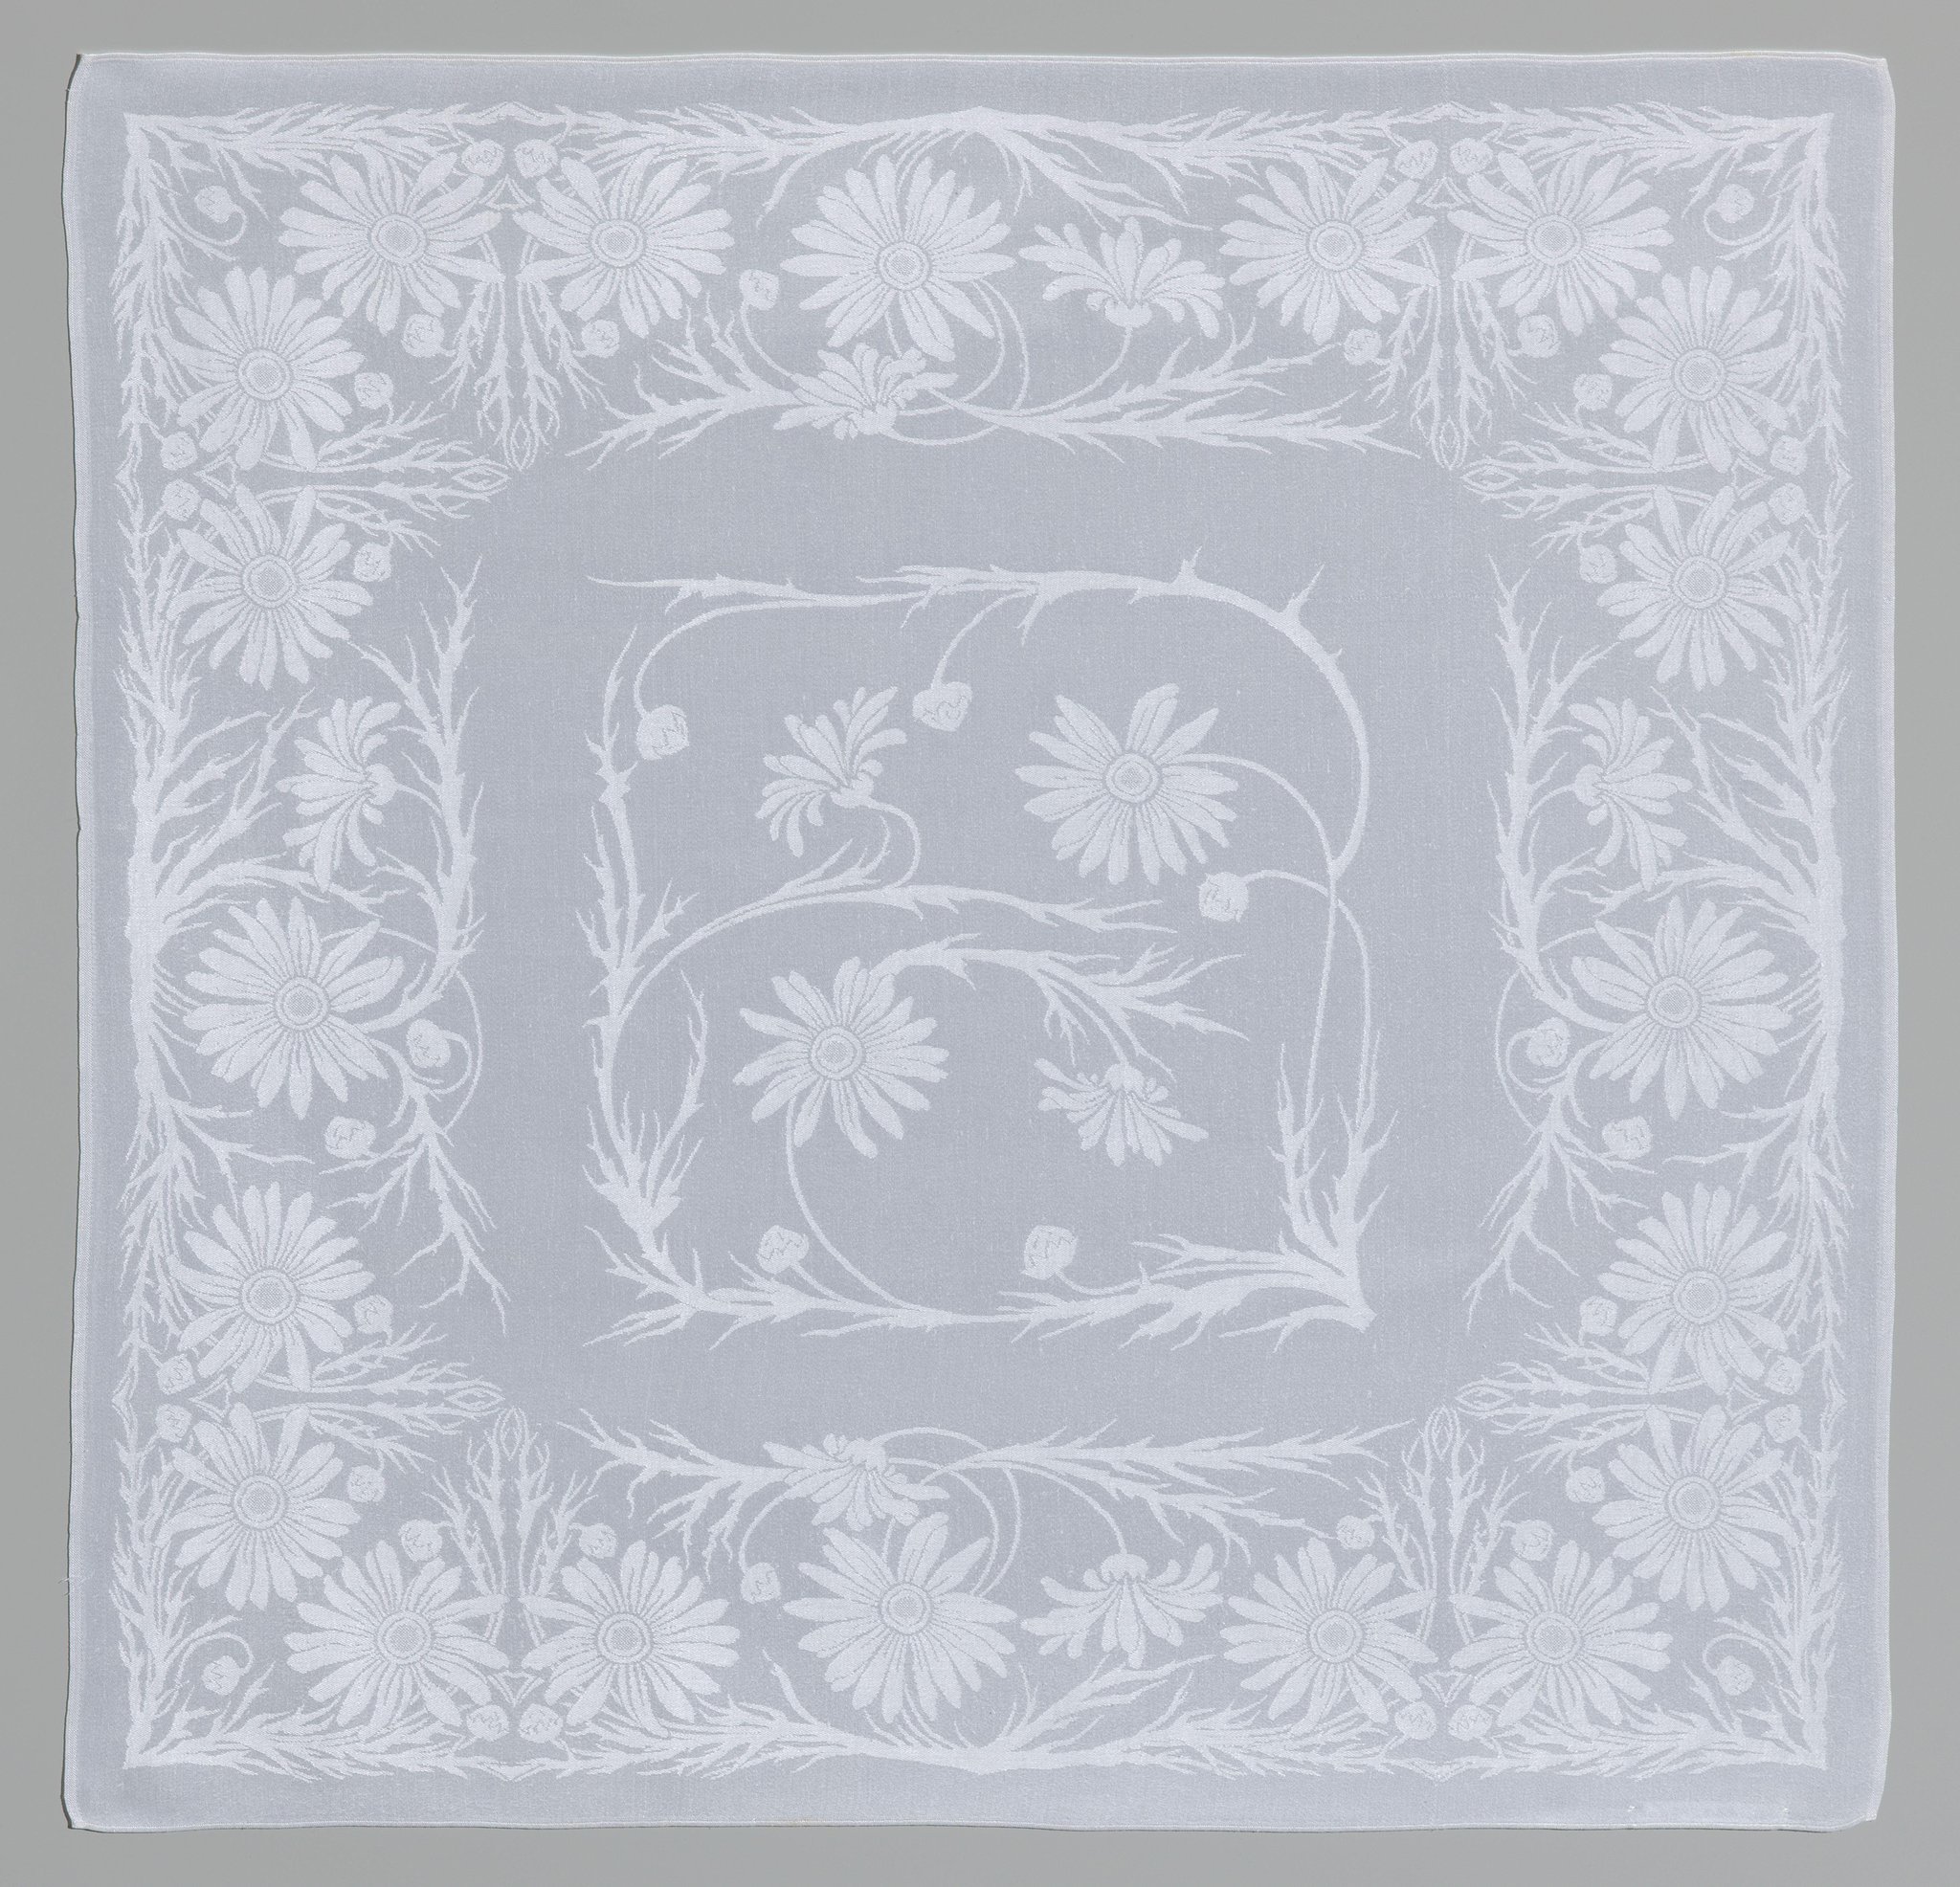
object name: napkin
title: Servet van linnendamast met dessin Marguerite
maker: cornelis van der sluys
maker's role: print maker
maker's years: 1881-1944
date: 1904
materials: linen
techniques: damask, weave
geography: eindhoven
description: Servet van linnendamast met een bloempatroon: motief Marguerite, dessin nr. 500. Het servet hoort bij twaalf servetten, twaalf vingerdoeken en een tafellaken.